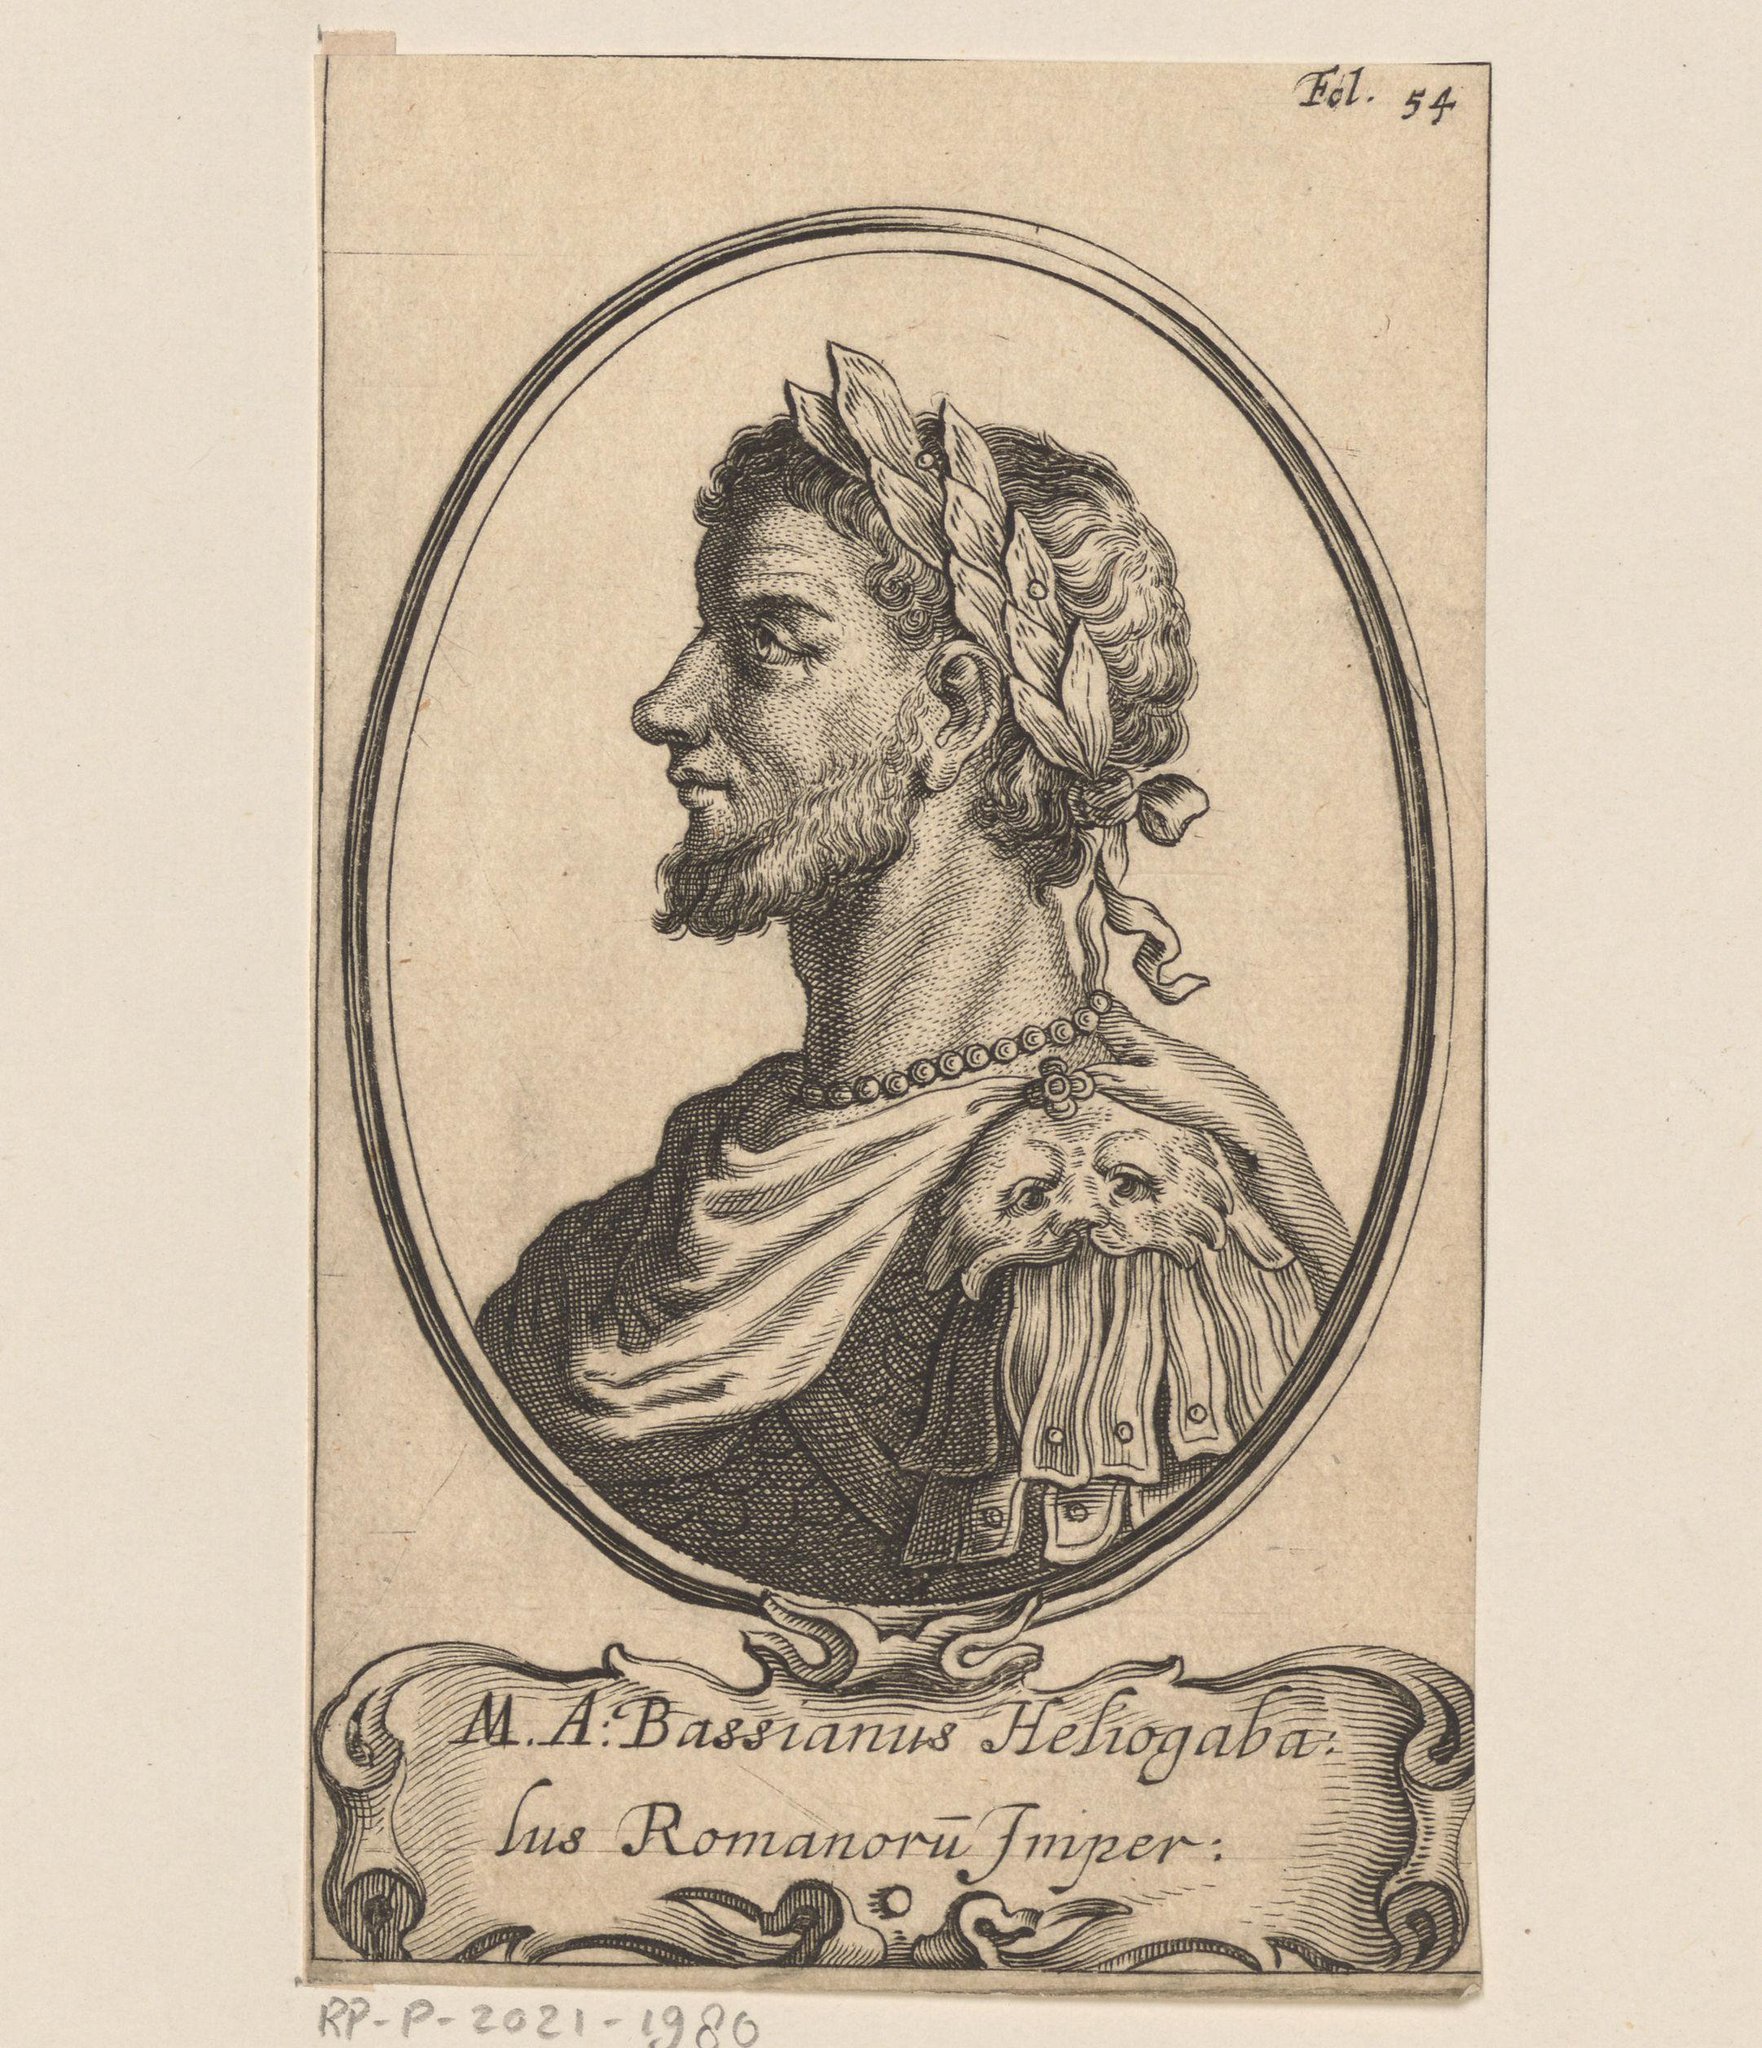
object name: print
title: Portret van keizer Elagabalus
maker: Anonymous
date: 1656-1659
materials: paper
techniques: engraving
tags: historical persons, emperor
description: Prent gebruikt in: Bos, Lambert van den. Het konincklyk treur-toonneel, ofte op- en ondergangh der keyseren, koningen en vorsten (...). Dordrecht: Jacobus Savry, 1656. Prent ook gebruikt in de 1659-editie.